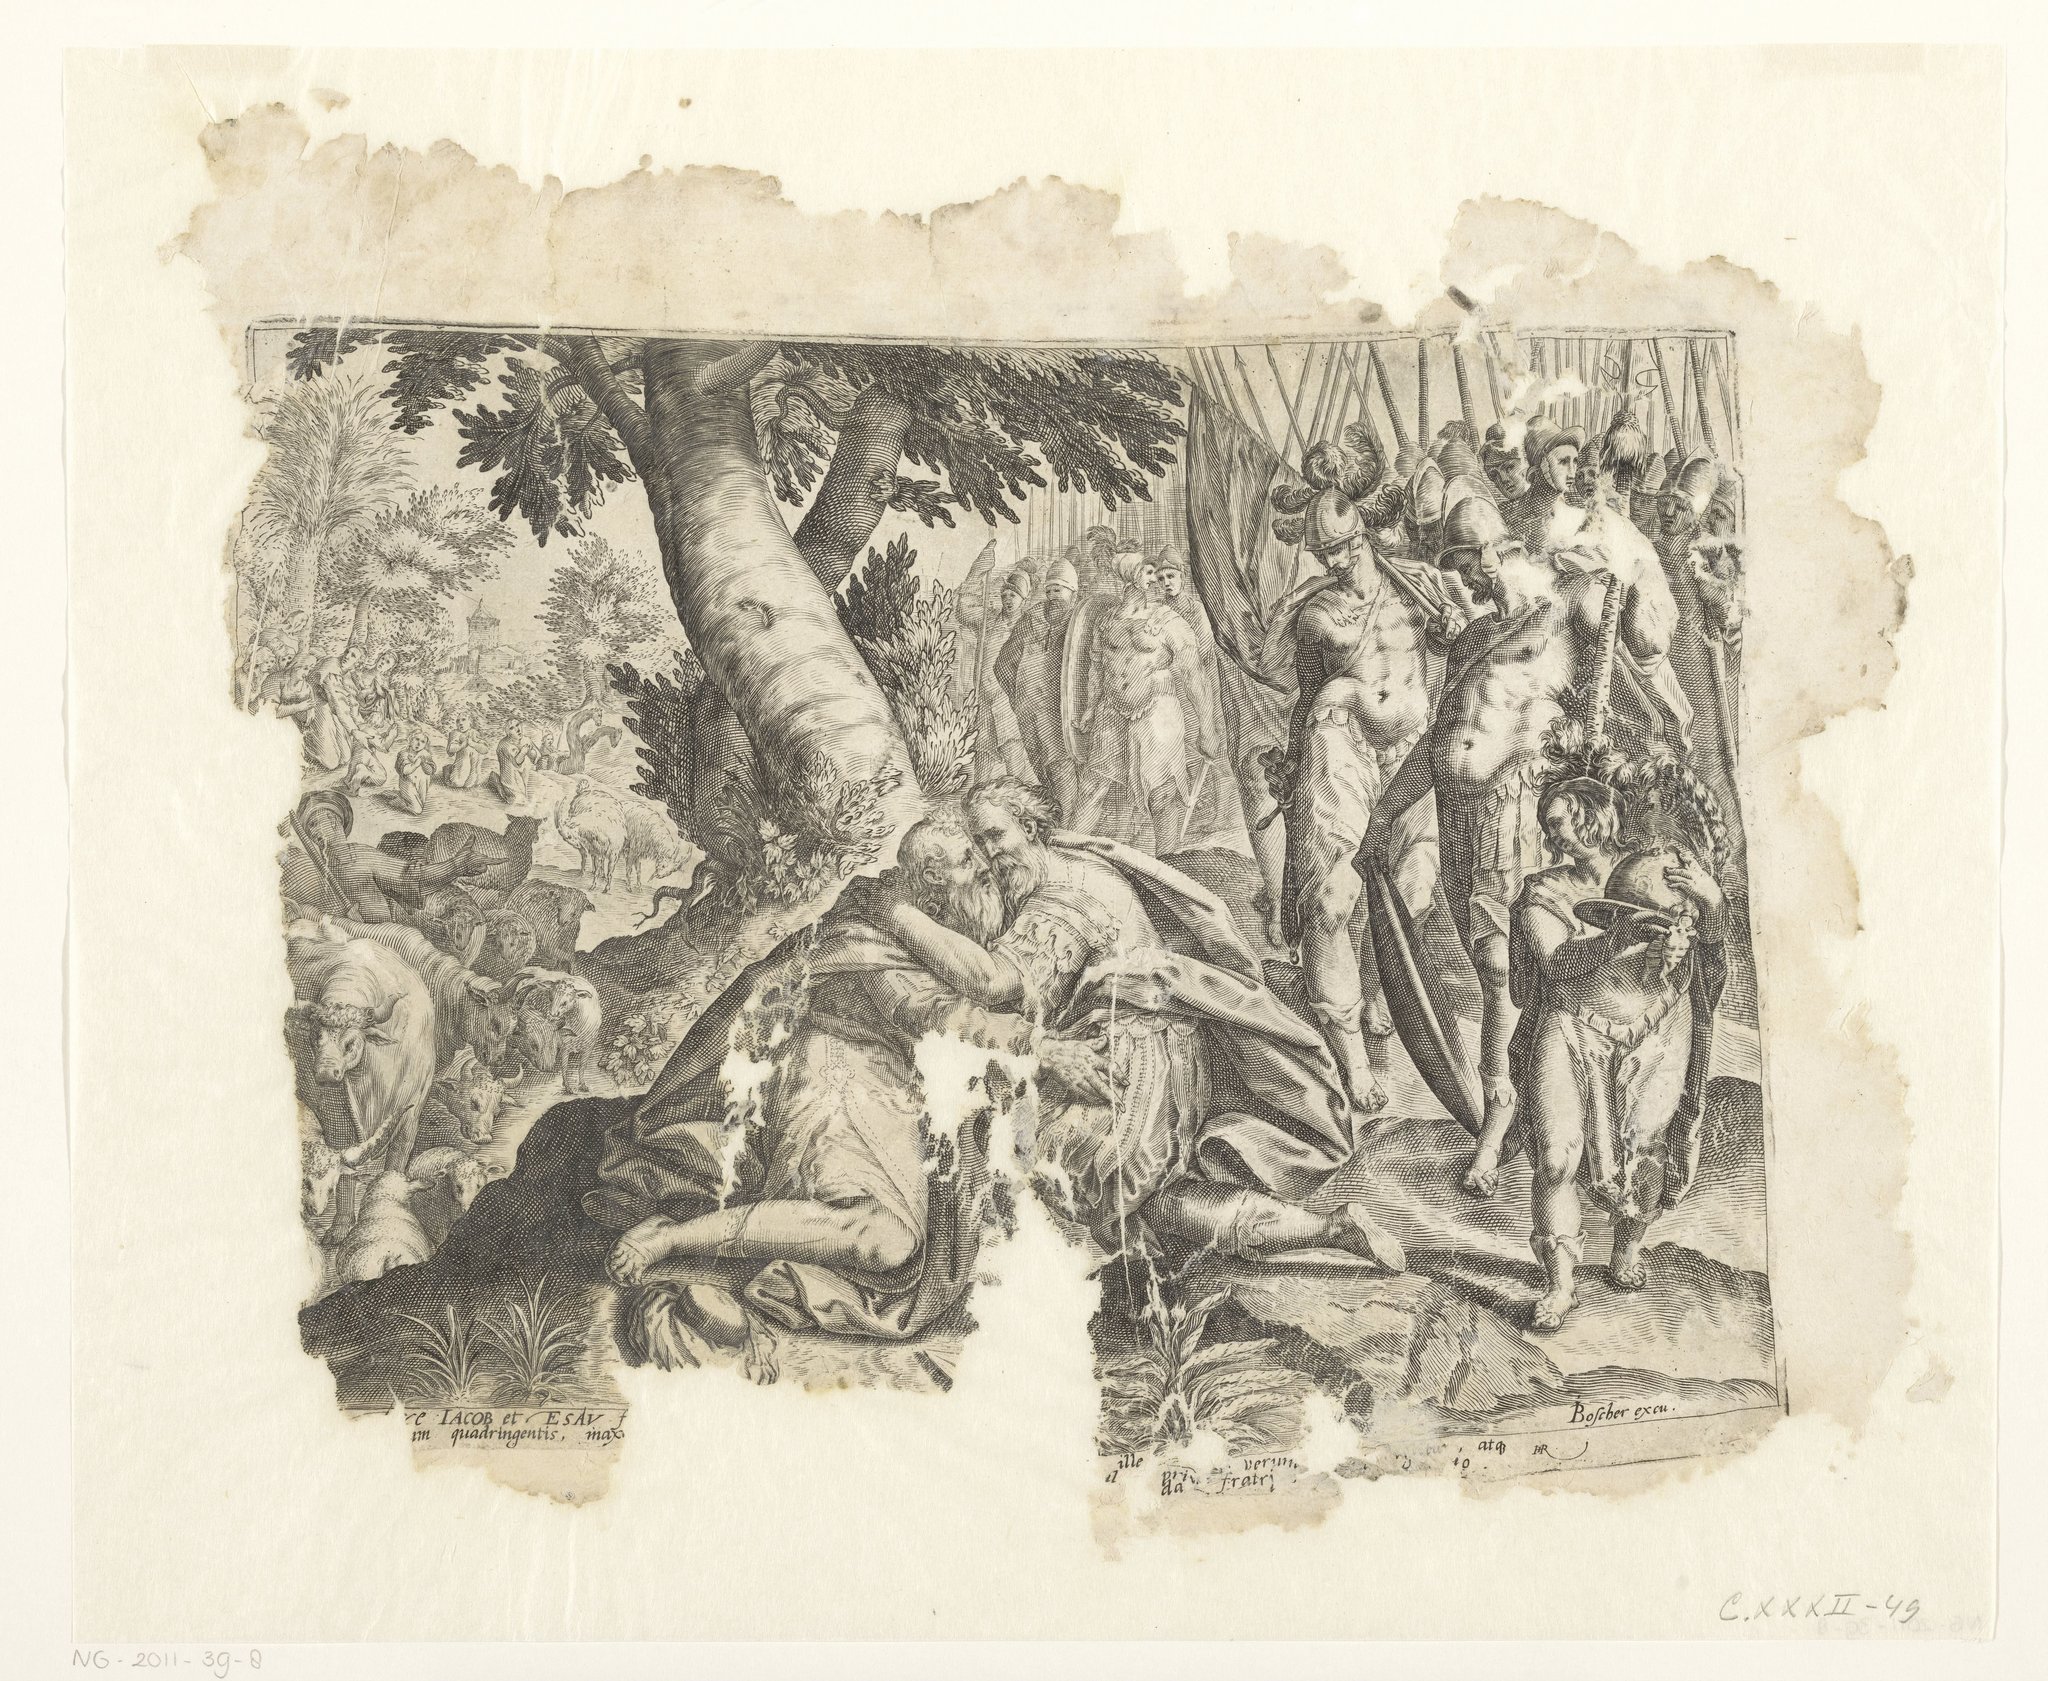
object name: print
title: Verzoening van Jakob en Esau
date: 1580-1596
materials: paper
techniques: engraving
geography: northern netherlands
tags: the meeting between esau and jacob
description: Tot dusverre was deze prent alleen bekend in een latere editie met het adres van C.J. Visscher in het door hem uitgegeven Theatrum Biblicum uit 1643, zie RP-P-1976-30-39. De prenten in de Nova Zembla collectie zijn tijdens een expeditie van Willem Barendsz en Jacob van Heemskerk in 1596-1597 noodgedwongen in het winterkamp, het ‘Behouden Huis’, op het eiland achtergelaten. De prenten waren in één of meerdere stapels als handelswaar meegenomen vanuit Amsterdam. Bijna drie eeuwen later, in 1871, keerde de Noor Elling Carlsen terug naar Nova Zembla en vond daar de restanten van het ‘Behouden Huis, inclusief een groot deel van de inventaris. Een deel van de prenten, in de vorm van aaneengekoekte kluiten, werd toen ook teruggevonden. De papierkluiten waren soms op meerdere plekken gebroken. Tussen 1975-1979 zijn de prenten van elkaar gescheiden. Dit leverde in totaal ca. 1000 fragmenten van ca. 400 afdrukken van ca. 150 verschillende prenten op. Voor zover mogelijk zijn de fragmenten samengevoegd en zijn de prenten gereconstrueerd.